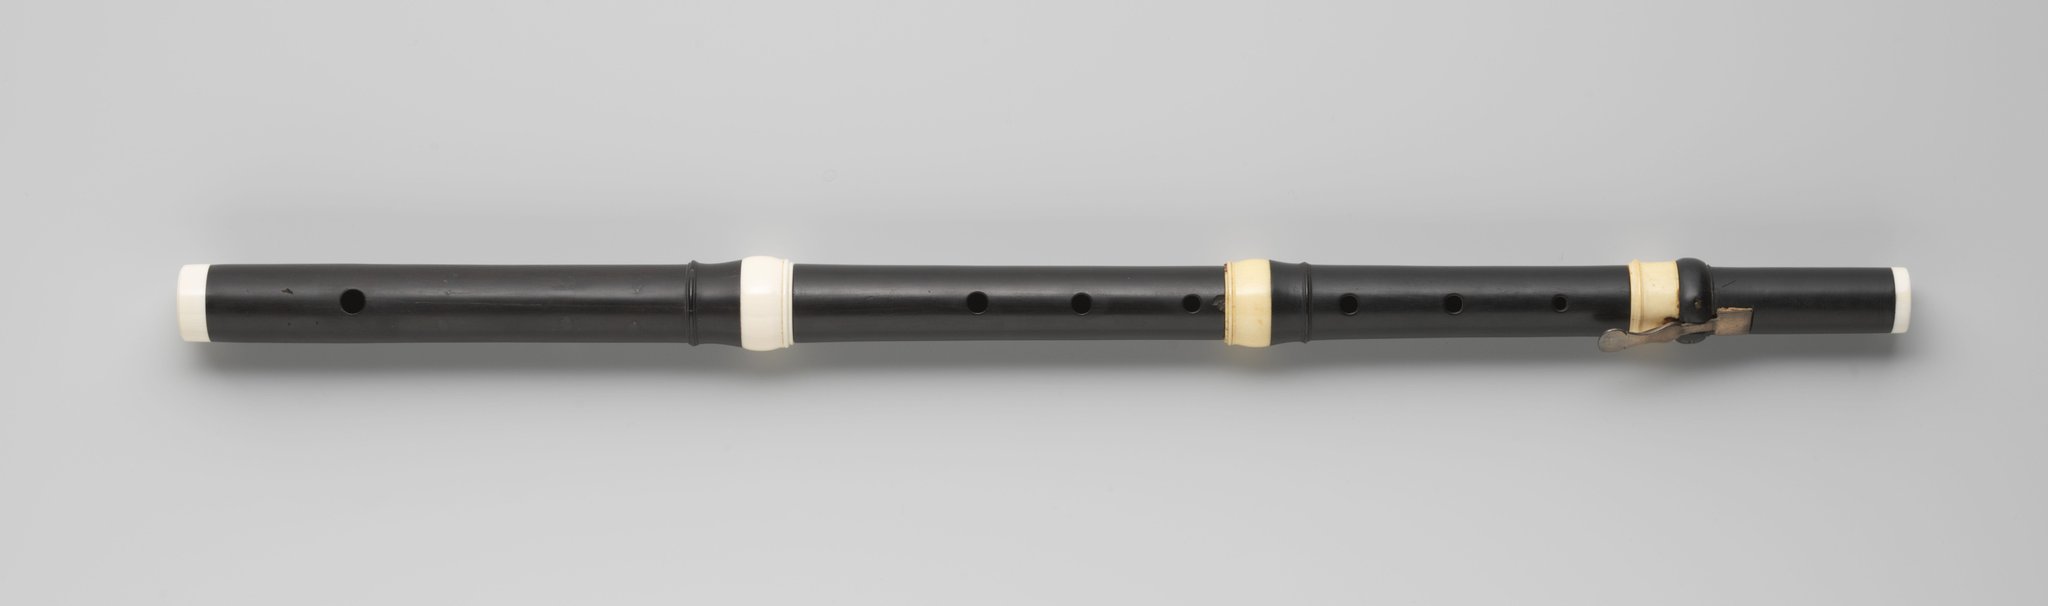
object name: musical instrument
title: Flute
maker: jan van heerde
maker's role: musical instrument maker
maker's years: 1704-1750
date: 1691-1720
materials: wood, ivory, silver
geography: amsterdam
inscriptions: stamp: ‘VAN HEERDE / [ongebreidelde leeuw]’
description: Vierdelige dwarsfluit van ebbehout met ringen van ivoor en een zilver klep (bij een stemming van a-415 Hz). Ondanks schade in de wand van de kop belangrijke elementen (mondgat, vingergaten, boring) in goede en originele staat bewaard waren gebleven. Stempel: 'VAN HEERDE / [ongebreidelde leeuw]'.